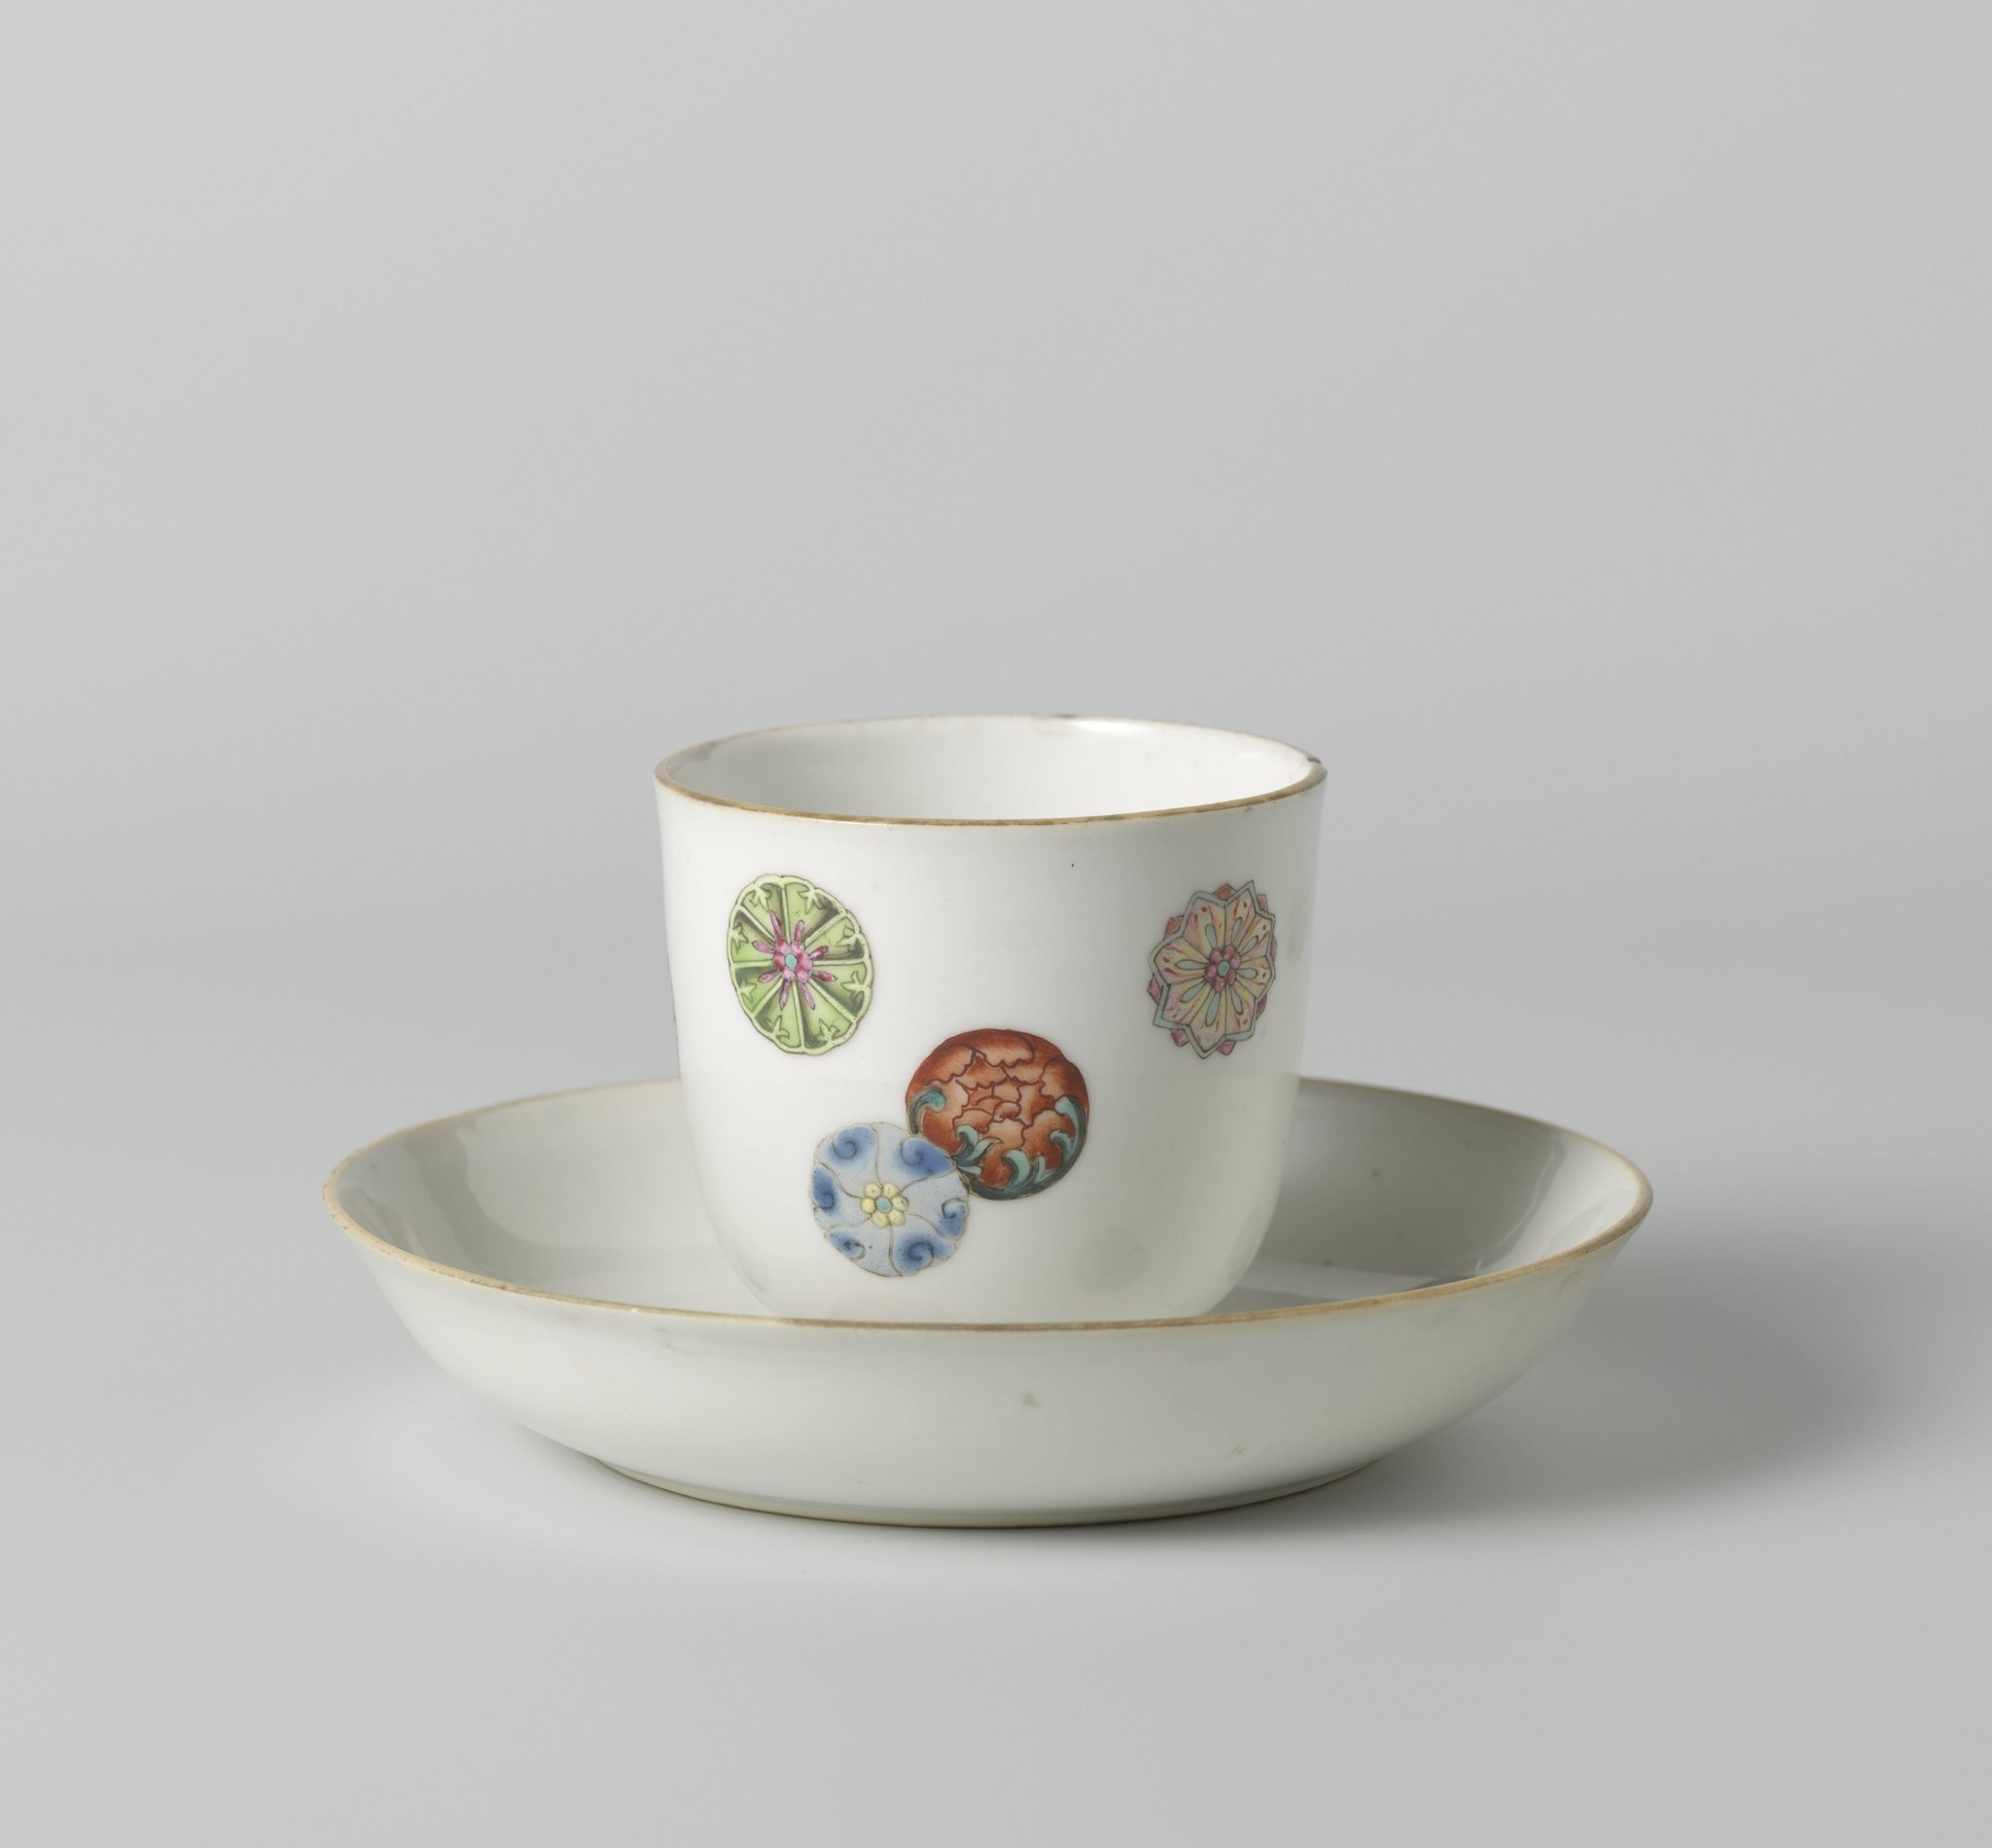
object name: kop en schotel, kop en schotel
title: Straight-sided cup and saucer with scattered stylised flowers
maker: Anonymous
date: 1840-1860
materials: glaze, paint, porcelain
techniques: firing, turning, vitrification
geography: china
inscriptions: mark: ‘大 清 乾 隆 年 製’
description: Kop en schotel van porselein met rechte wand, beschilderd op het glazuur in blauw, rood, roze, groen, geel en zwart. Op de voorzijde van de schotel zeven losse, gestileerde bloemen. De kop met dezelfde decoratie. Beide gemerkt op de onderzijde met het zes-karakter zegelmerk van keizer Qianlong. Een chip in de rand van de kop. Famille rose.